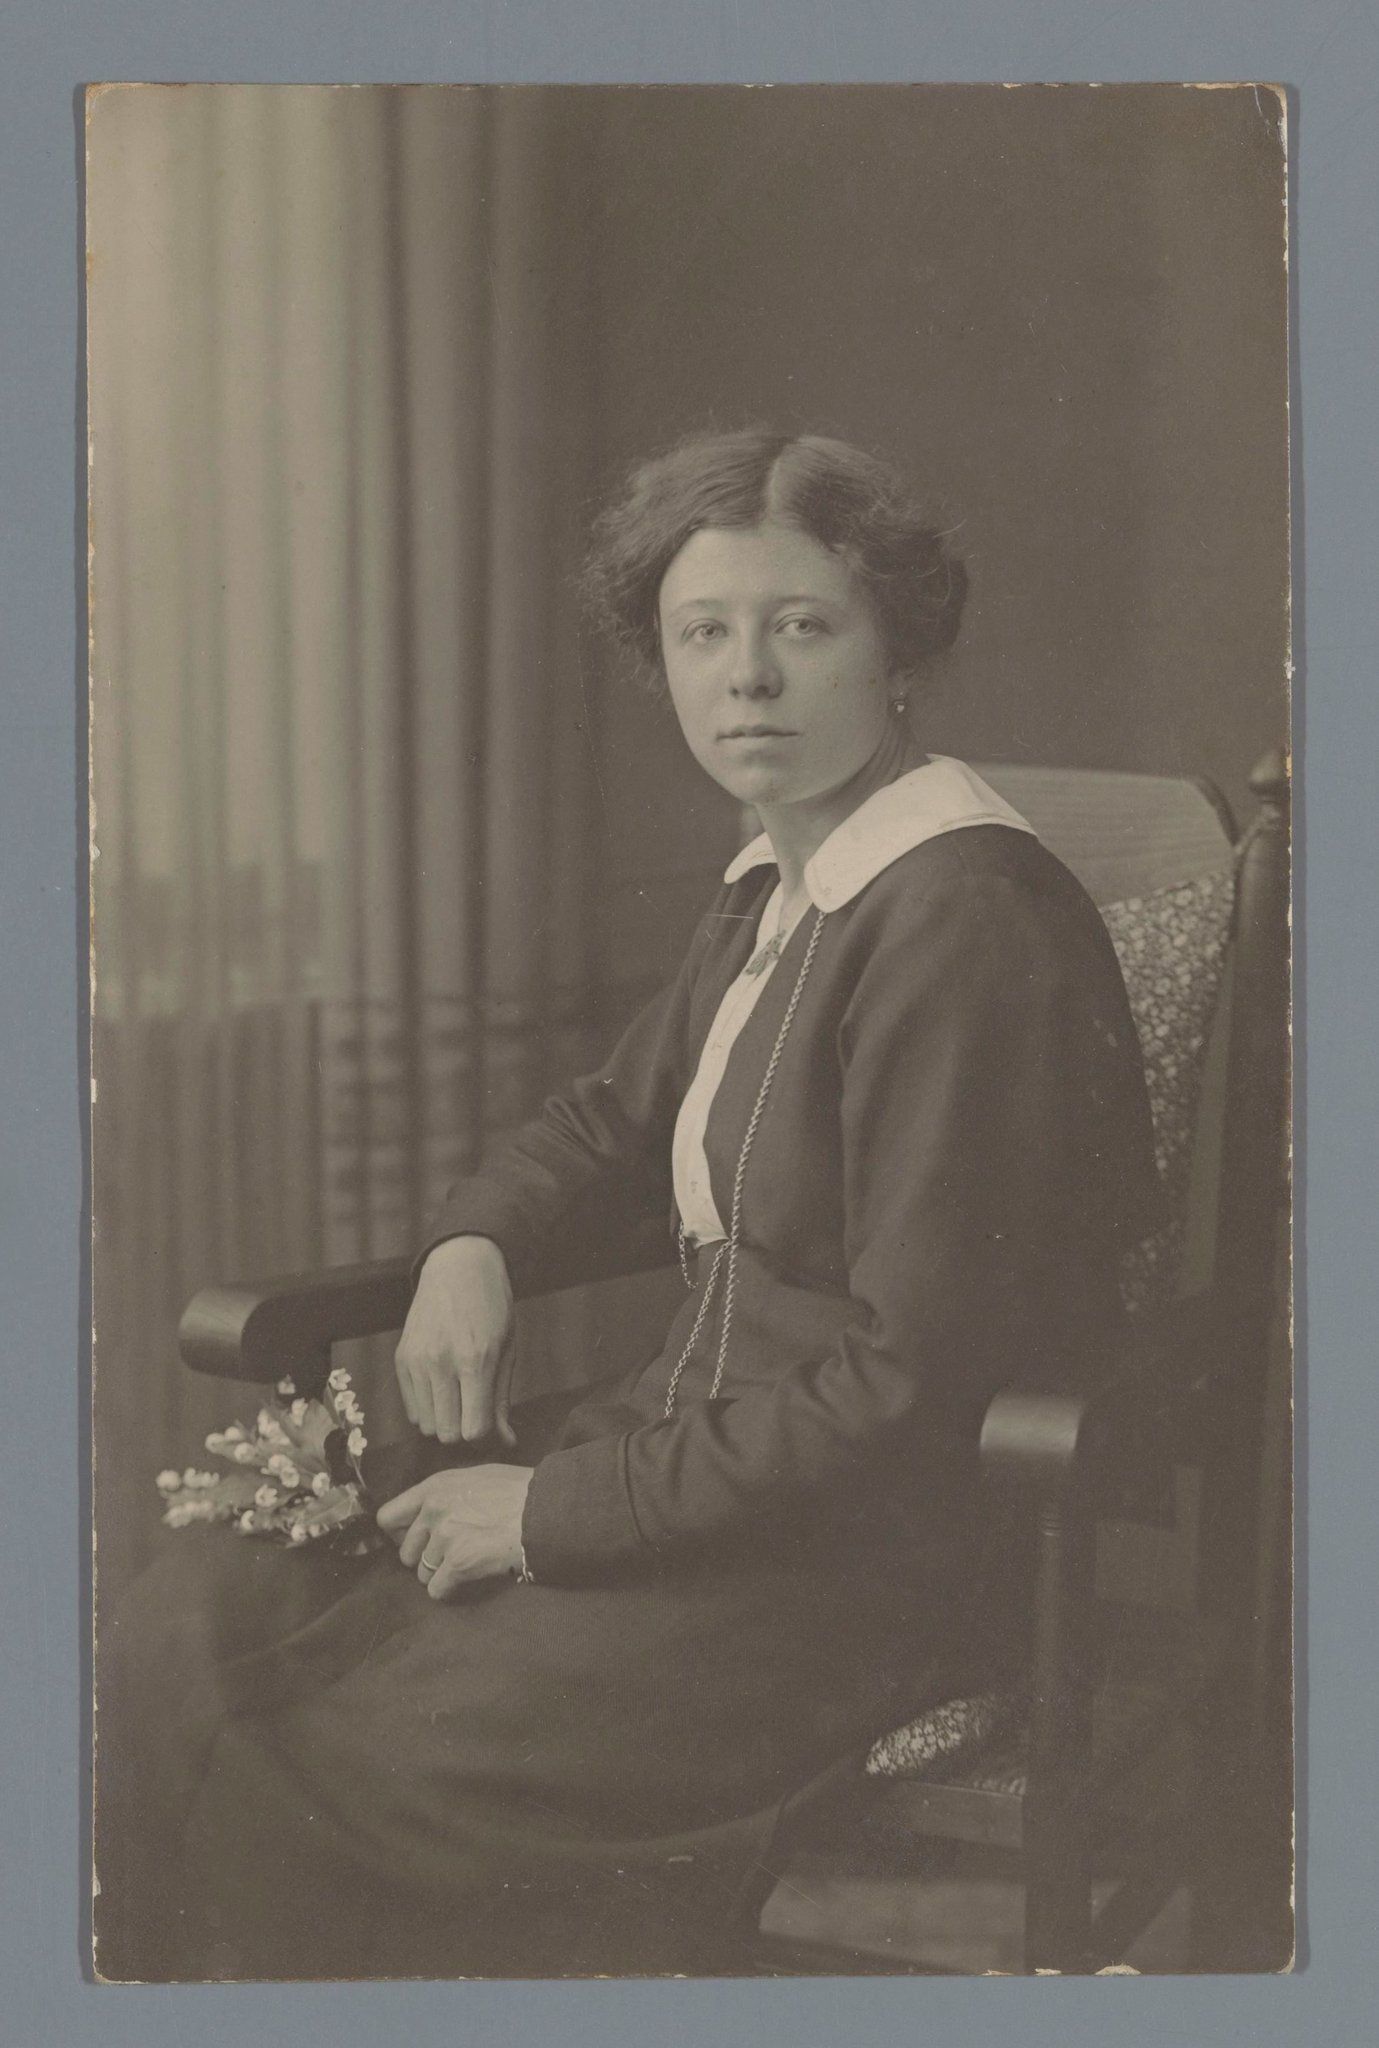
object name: photograph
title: Portret van een onbekende vrouw op een stoel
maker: b. brandsma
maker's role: fotograaf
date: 1920-1940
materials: photographic support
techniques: gelatin silver print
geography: amsterdam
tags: adult woman, chair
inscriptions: inscription: ‘B. Brandsma, Ceintuurbaan 23, Amsterdam’